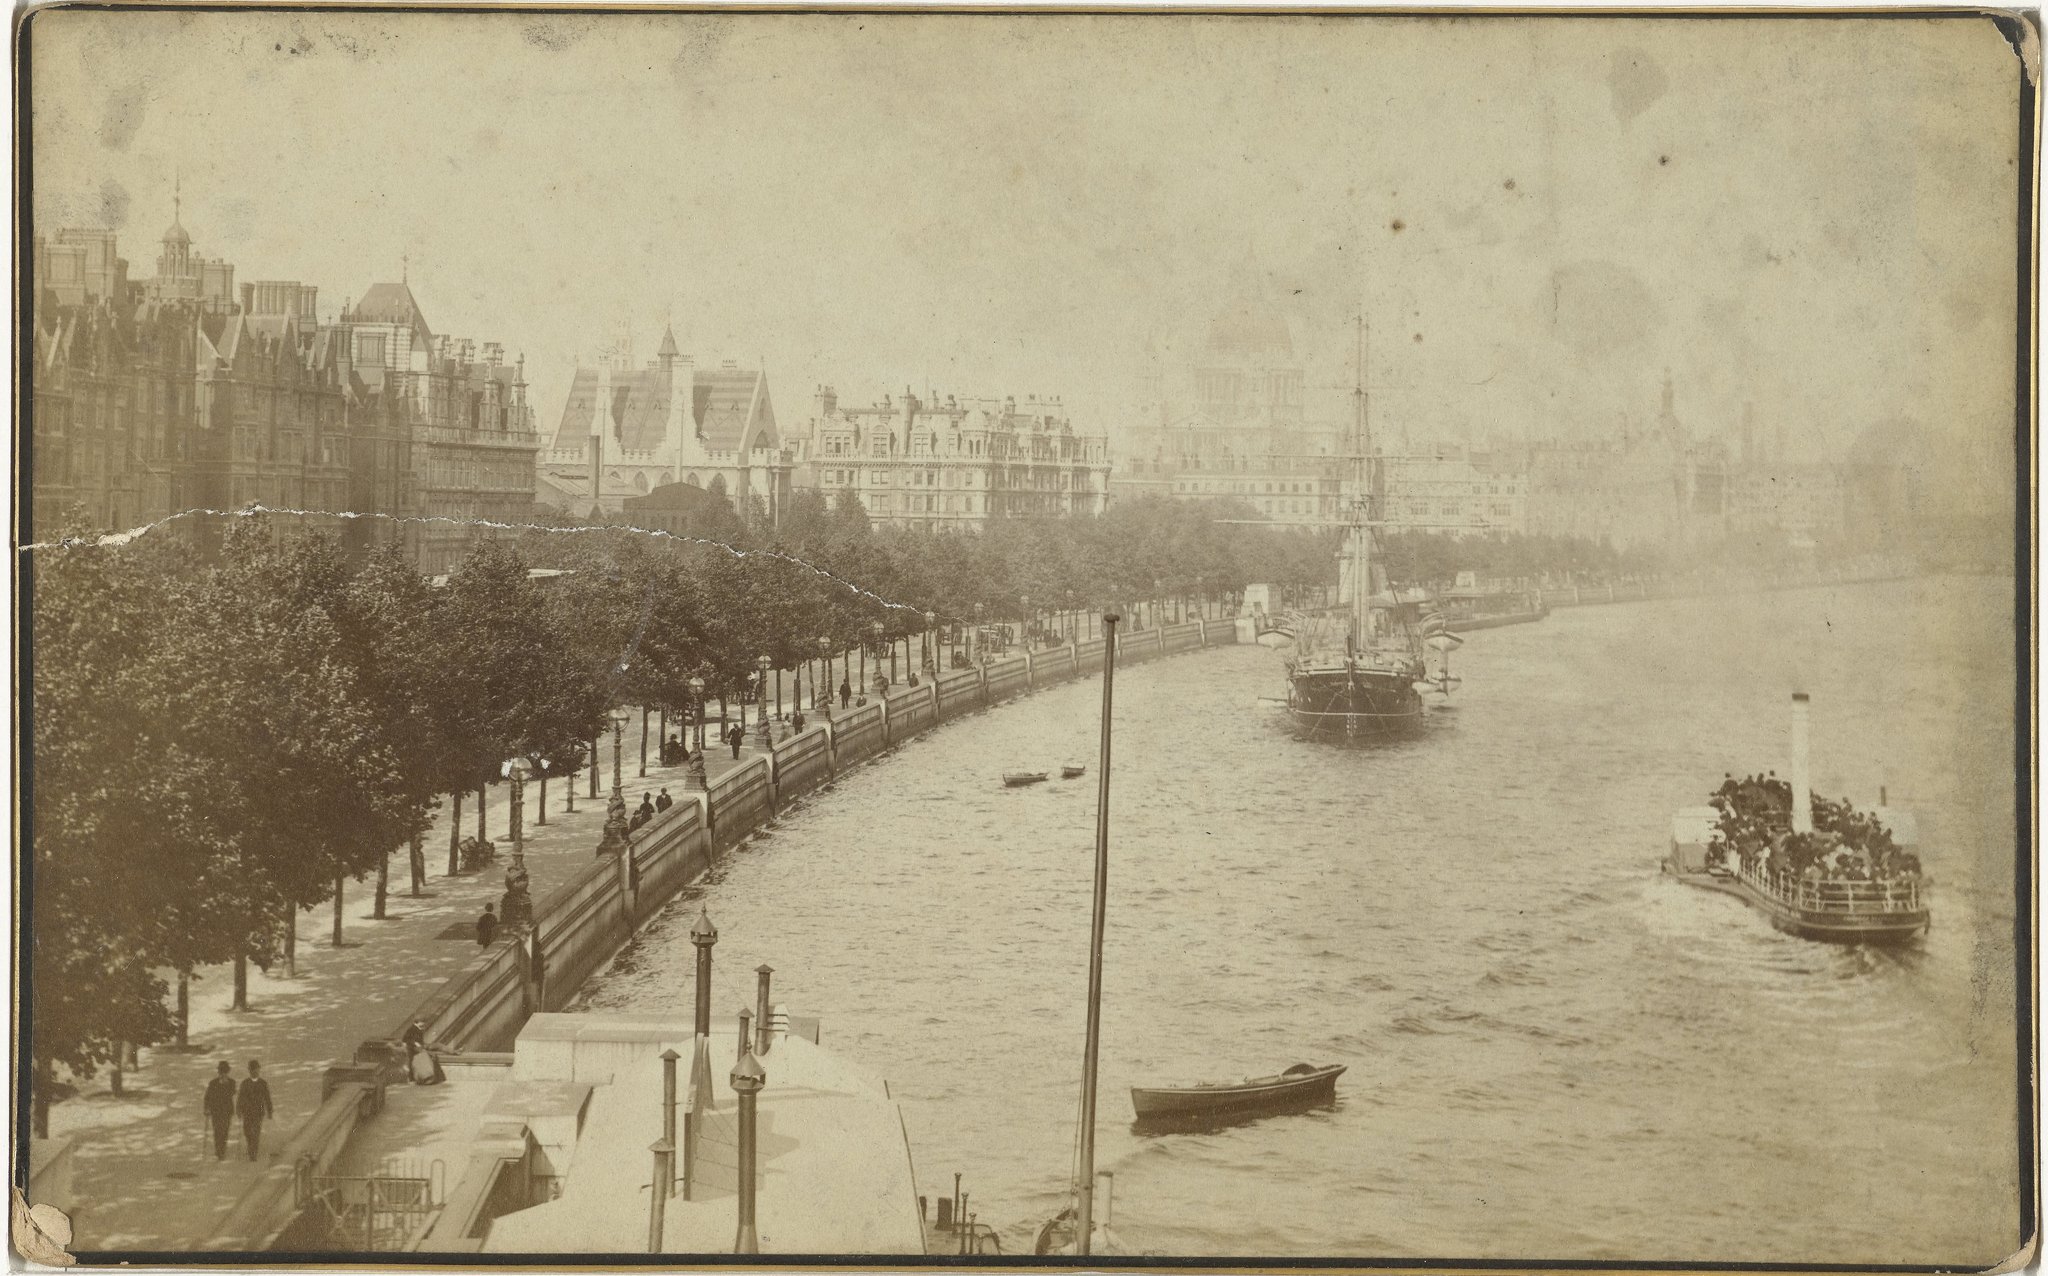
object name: photograph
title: Gezicht op de Theems in Londen, met Saint Paul's Cathedral op de achtergrond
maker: Anonymous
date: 1892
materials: cardboard, paper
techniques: albumen print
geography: london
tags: canals, waters (in city), thames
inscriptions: number: ‘no 1852’